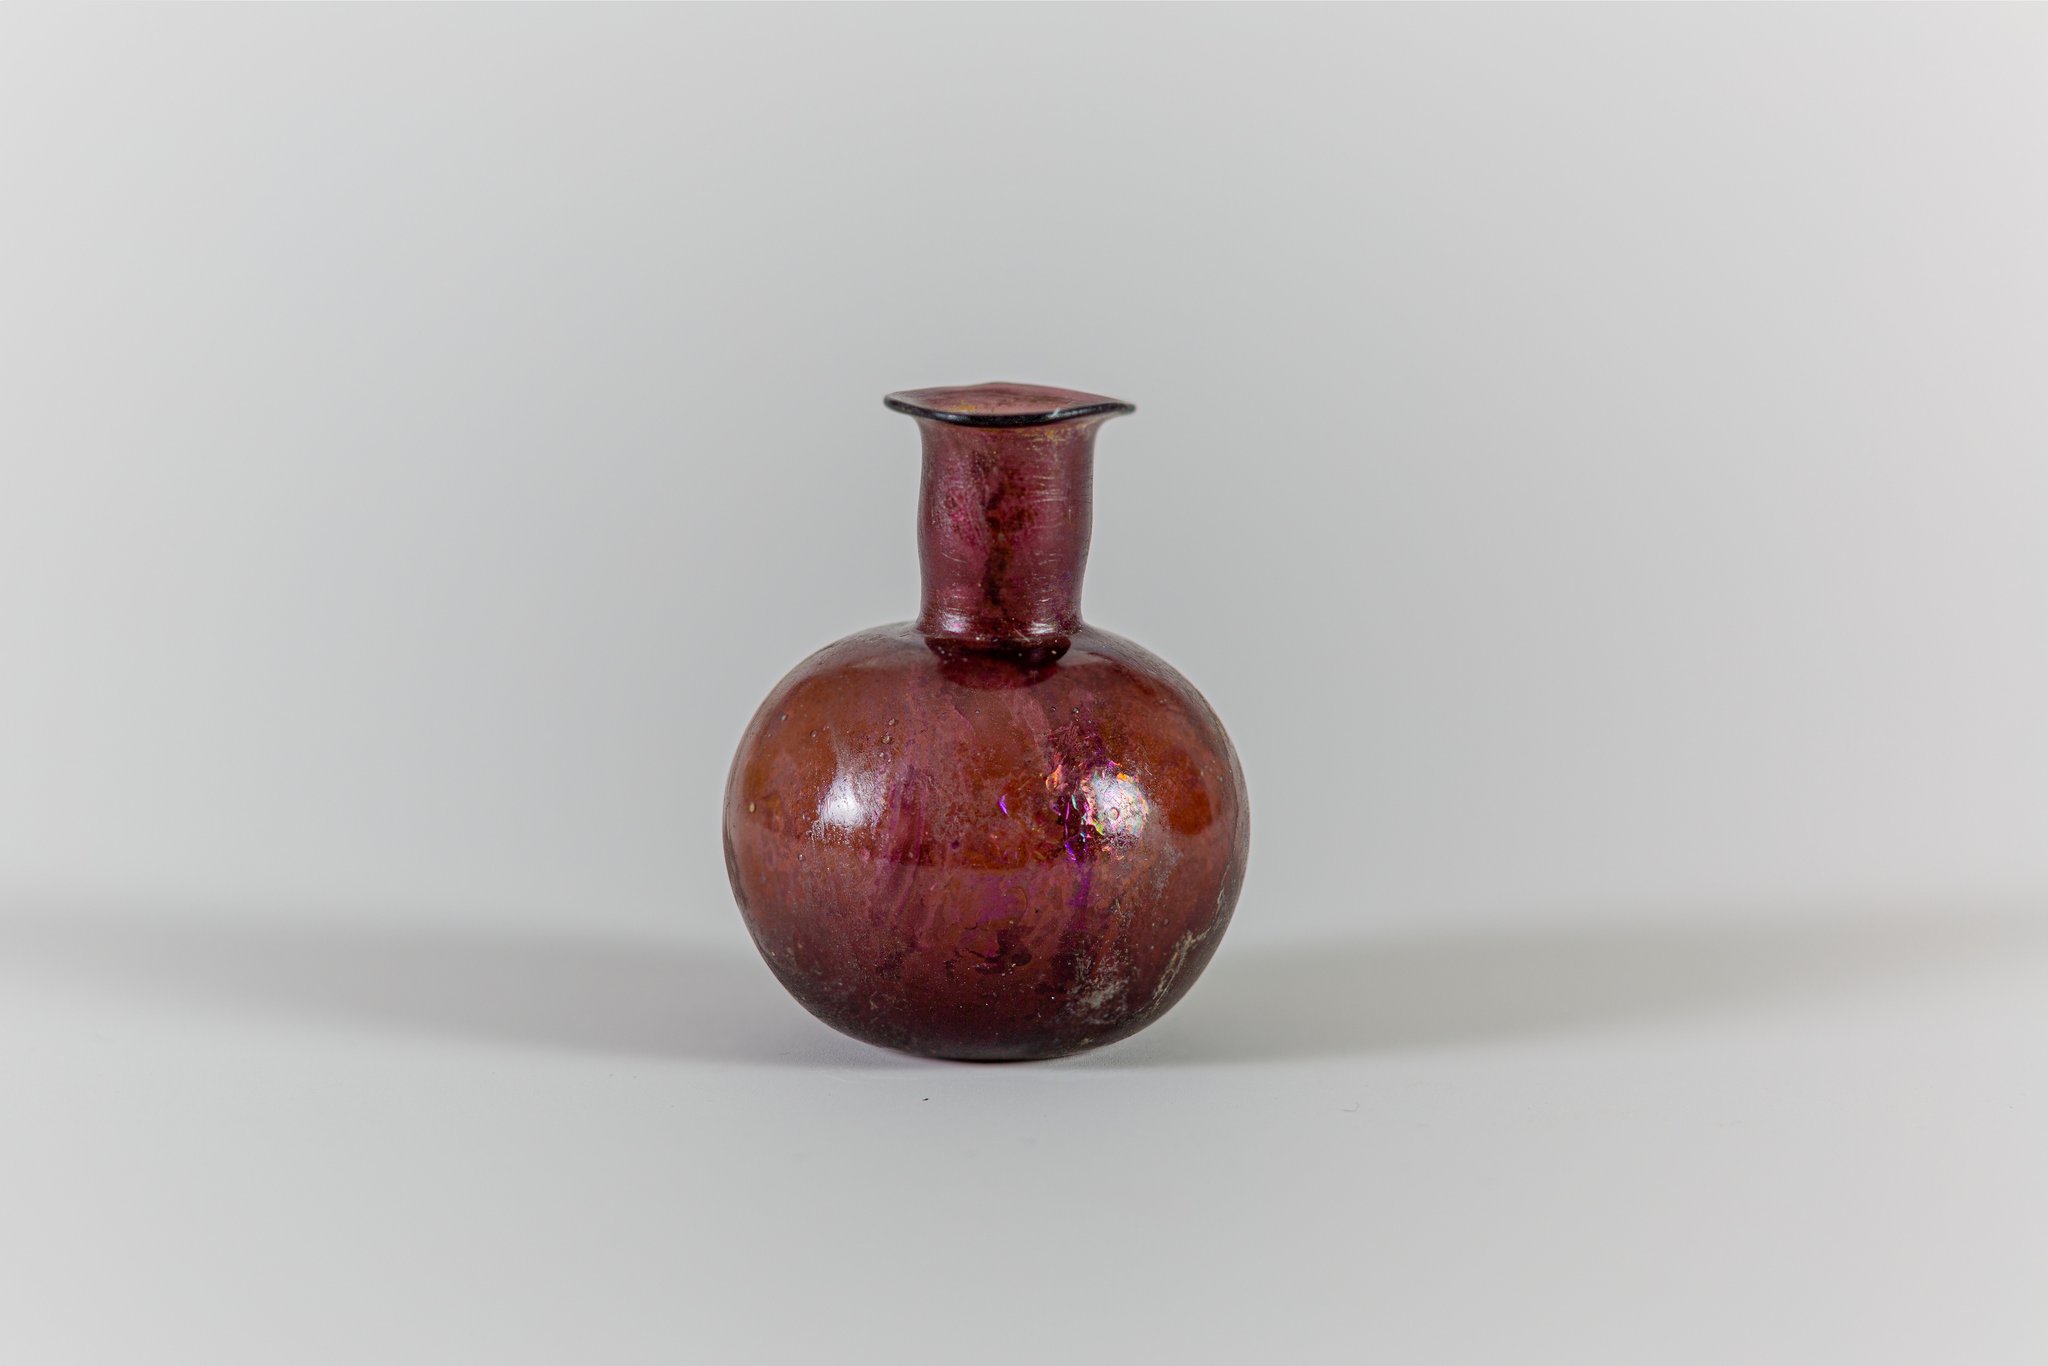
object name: perfume bottle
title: Glass perfume bottle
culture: roman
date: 1-100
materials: glass